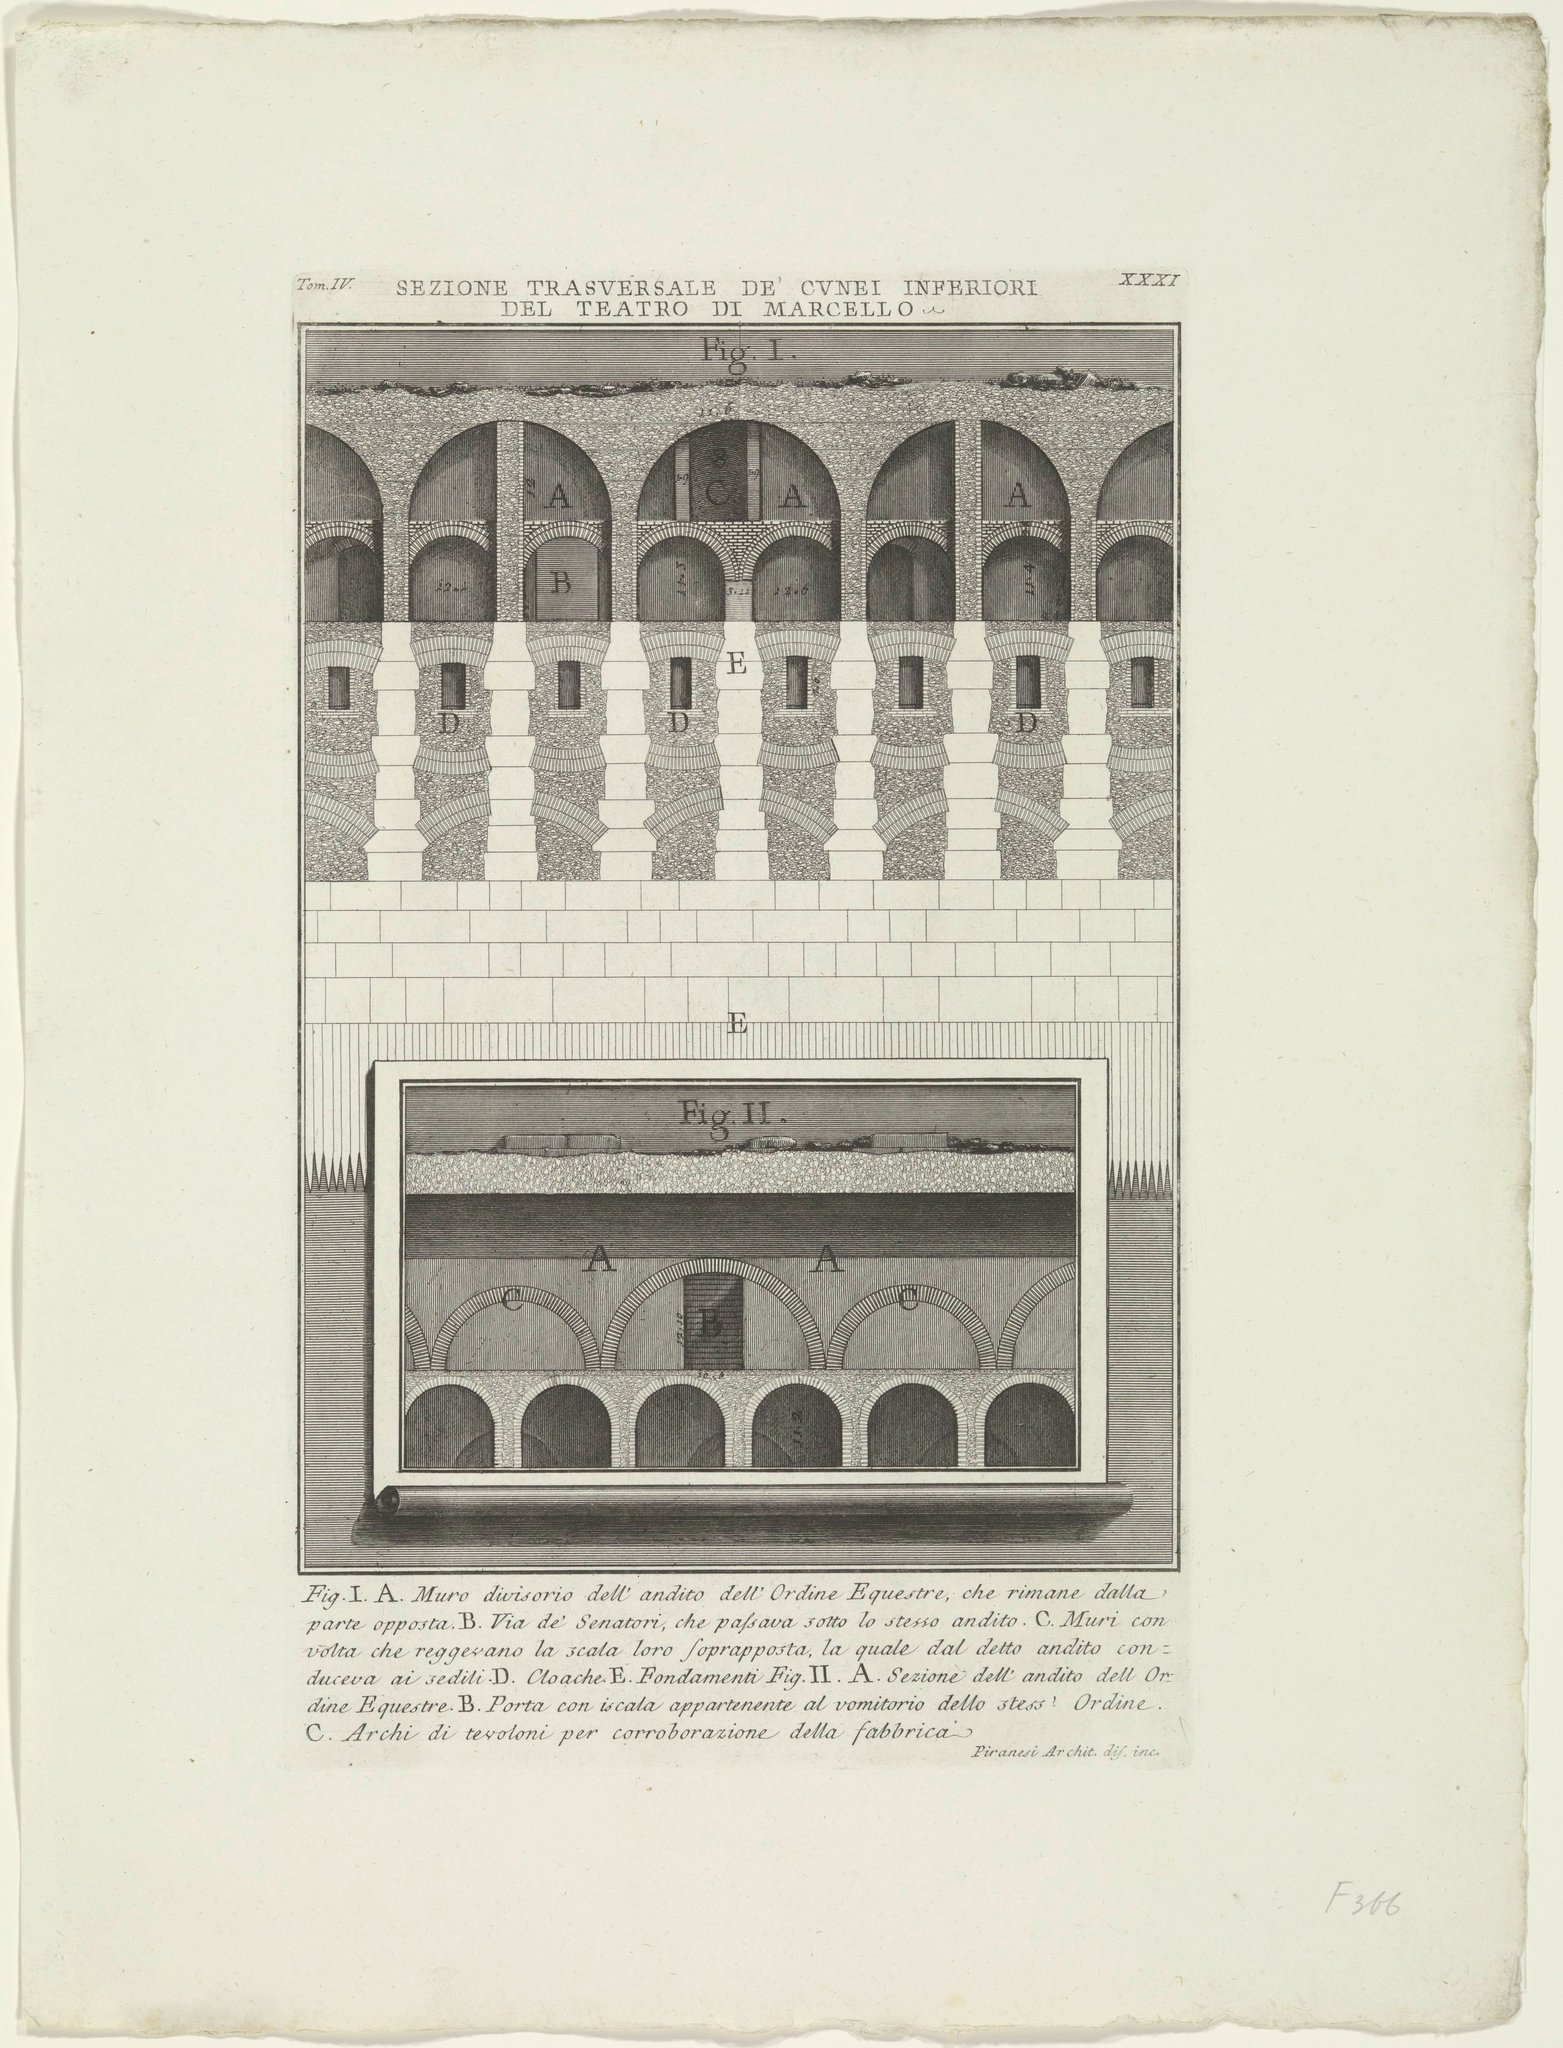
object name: print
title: Sezione trasversale de' cunei inferiori del teatro di Marcello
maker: giovanni battista piranesi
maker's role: designer, draughtsman, print maker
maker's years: 1720-1778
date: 1756-1757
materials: paper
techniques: etching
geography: rome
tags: ruin of a building ~ architecture, theatre (building), plan ~ architecture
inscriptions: collector's mark: Lugt 2228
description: Deze prent maakt deel uit van de serie 'Le Antichità Romane'. Piranesi deed meer dan acht jaar voorstudie voor deze 250 platen tellende serie die in vier volumes werd uitgegeven. Hij produceerde de prenten tussen ca. 1756 en 1757. De serie bevat ook prenten door of naar andere prentmakers, onder wie Francesco Bianchini en Girolamo Rossi.